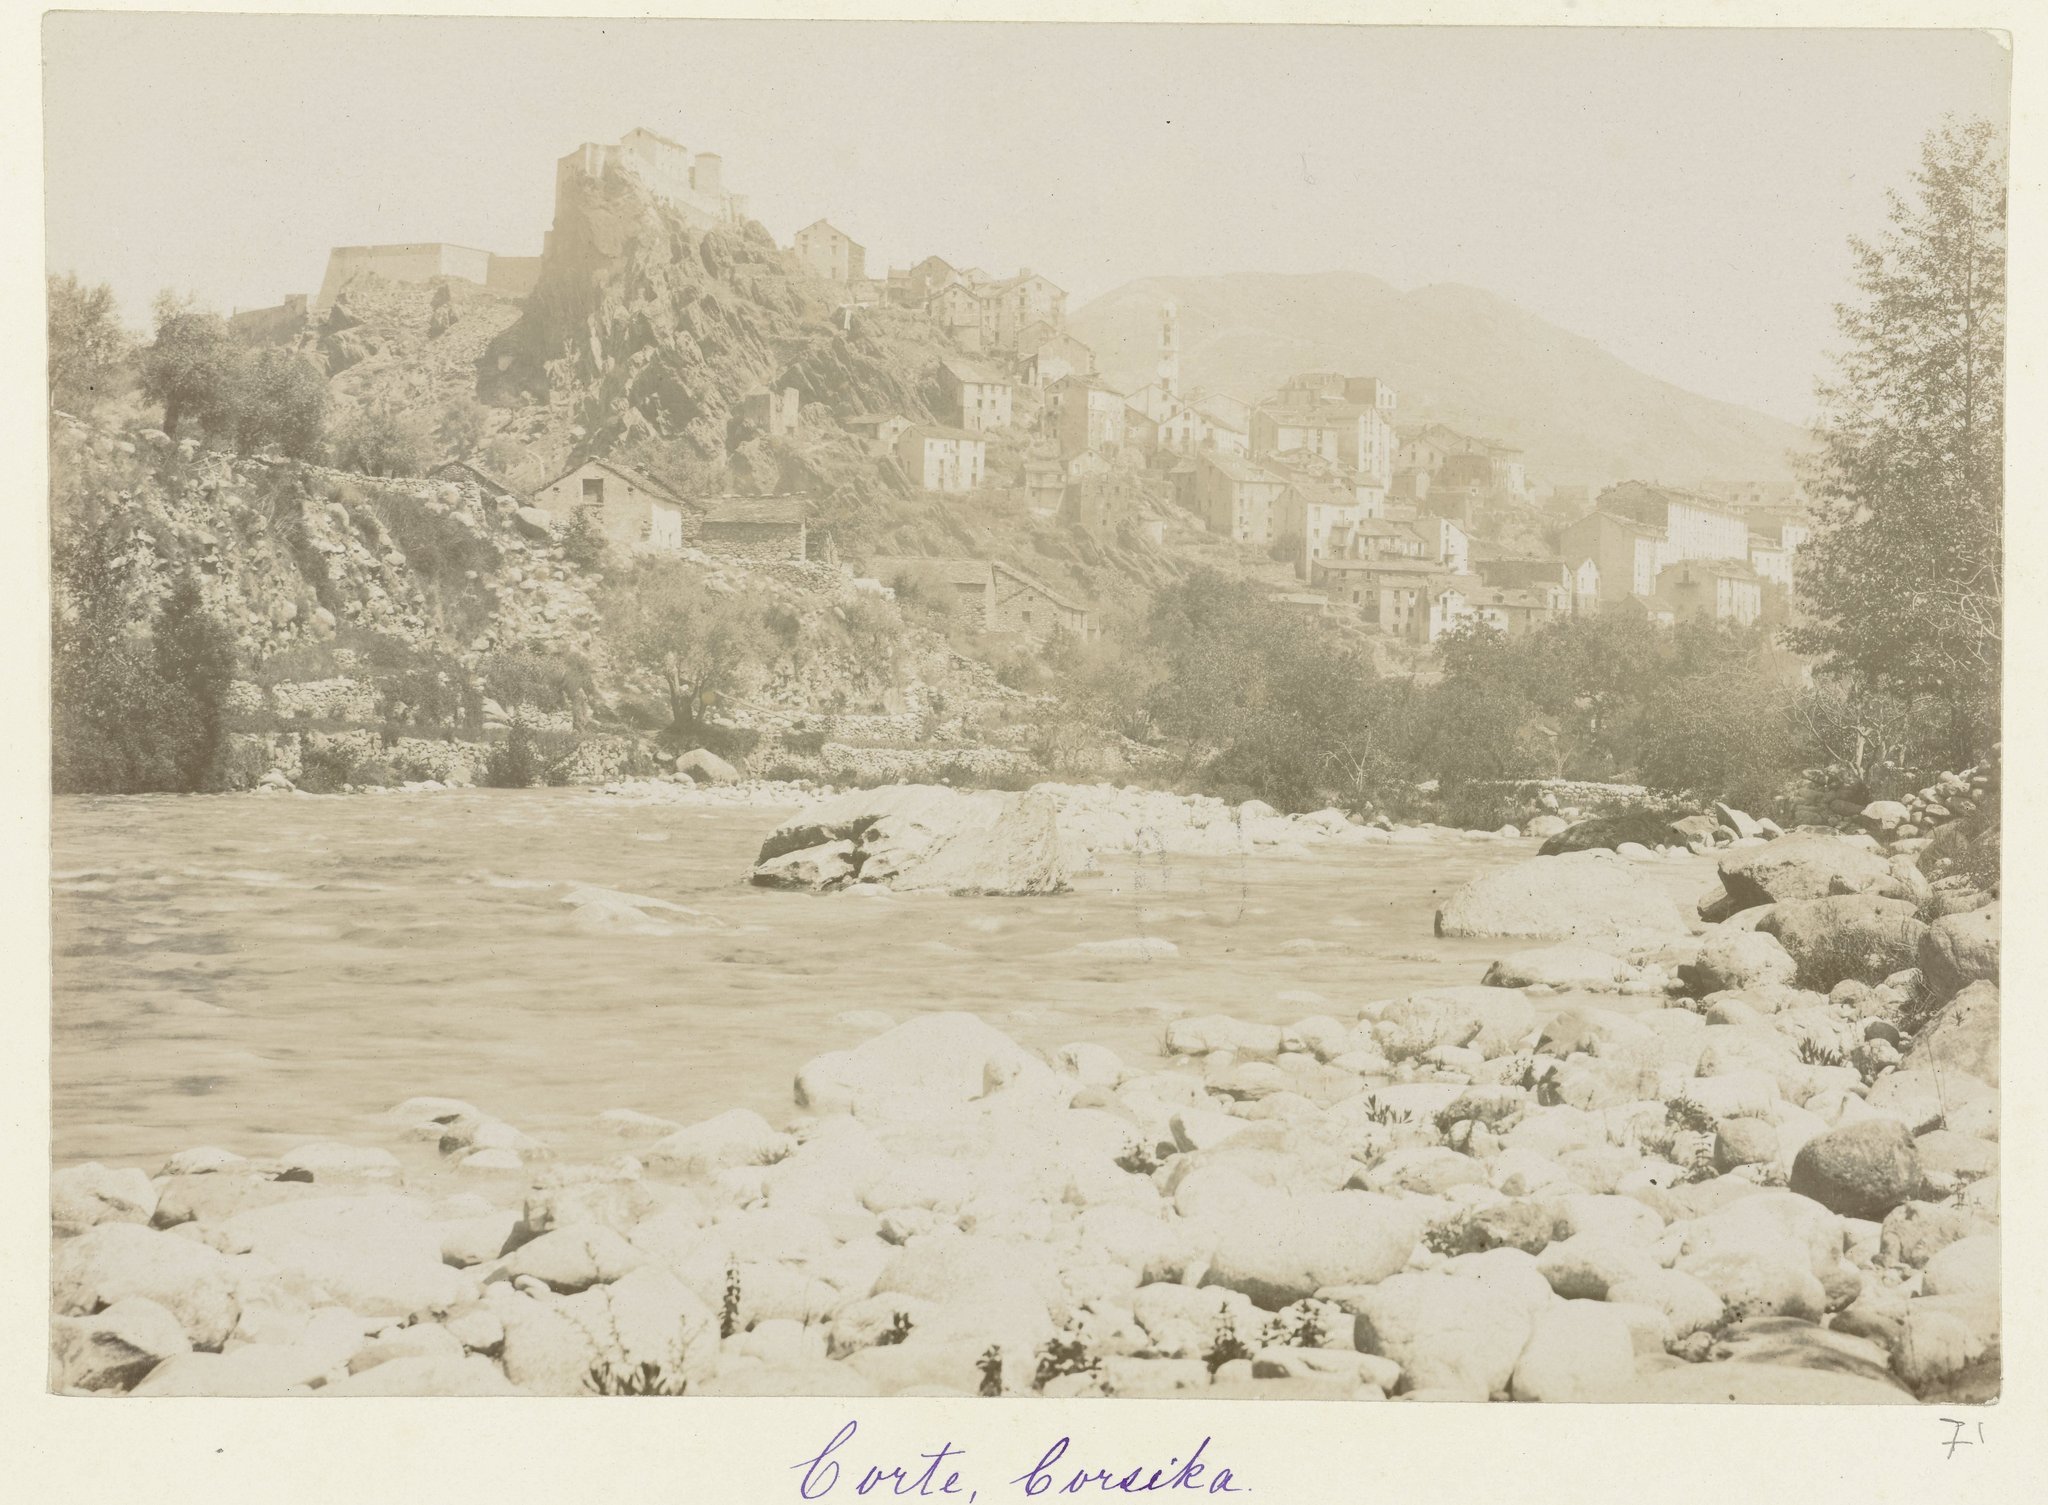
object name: photograph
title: Corte , Corsika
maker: henry pauw van wieldrecht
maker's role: fotograaf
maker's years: 1863-1912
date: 1886-1896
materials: cardboard, photographic support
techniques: albumen print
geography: corsica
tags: corsica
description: De stad Corte gezien vanaf de andere oever van de Tavignano. De stad Corte is gebouwd op een heuvel in het Corsicaanse berglandschap.